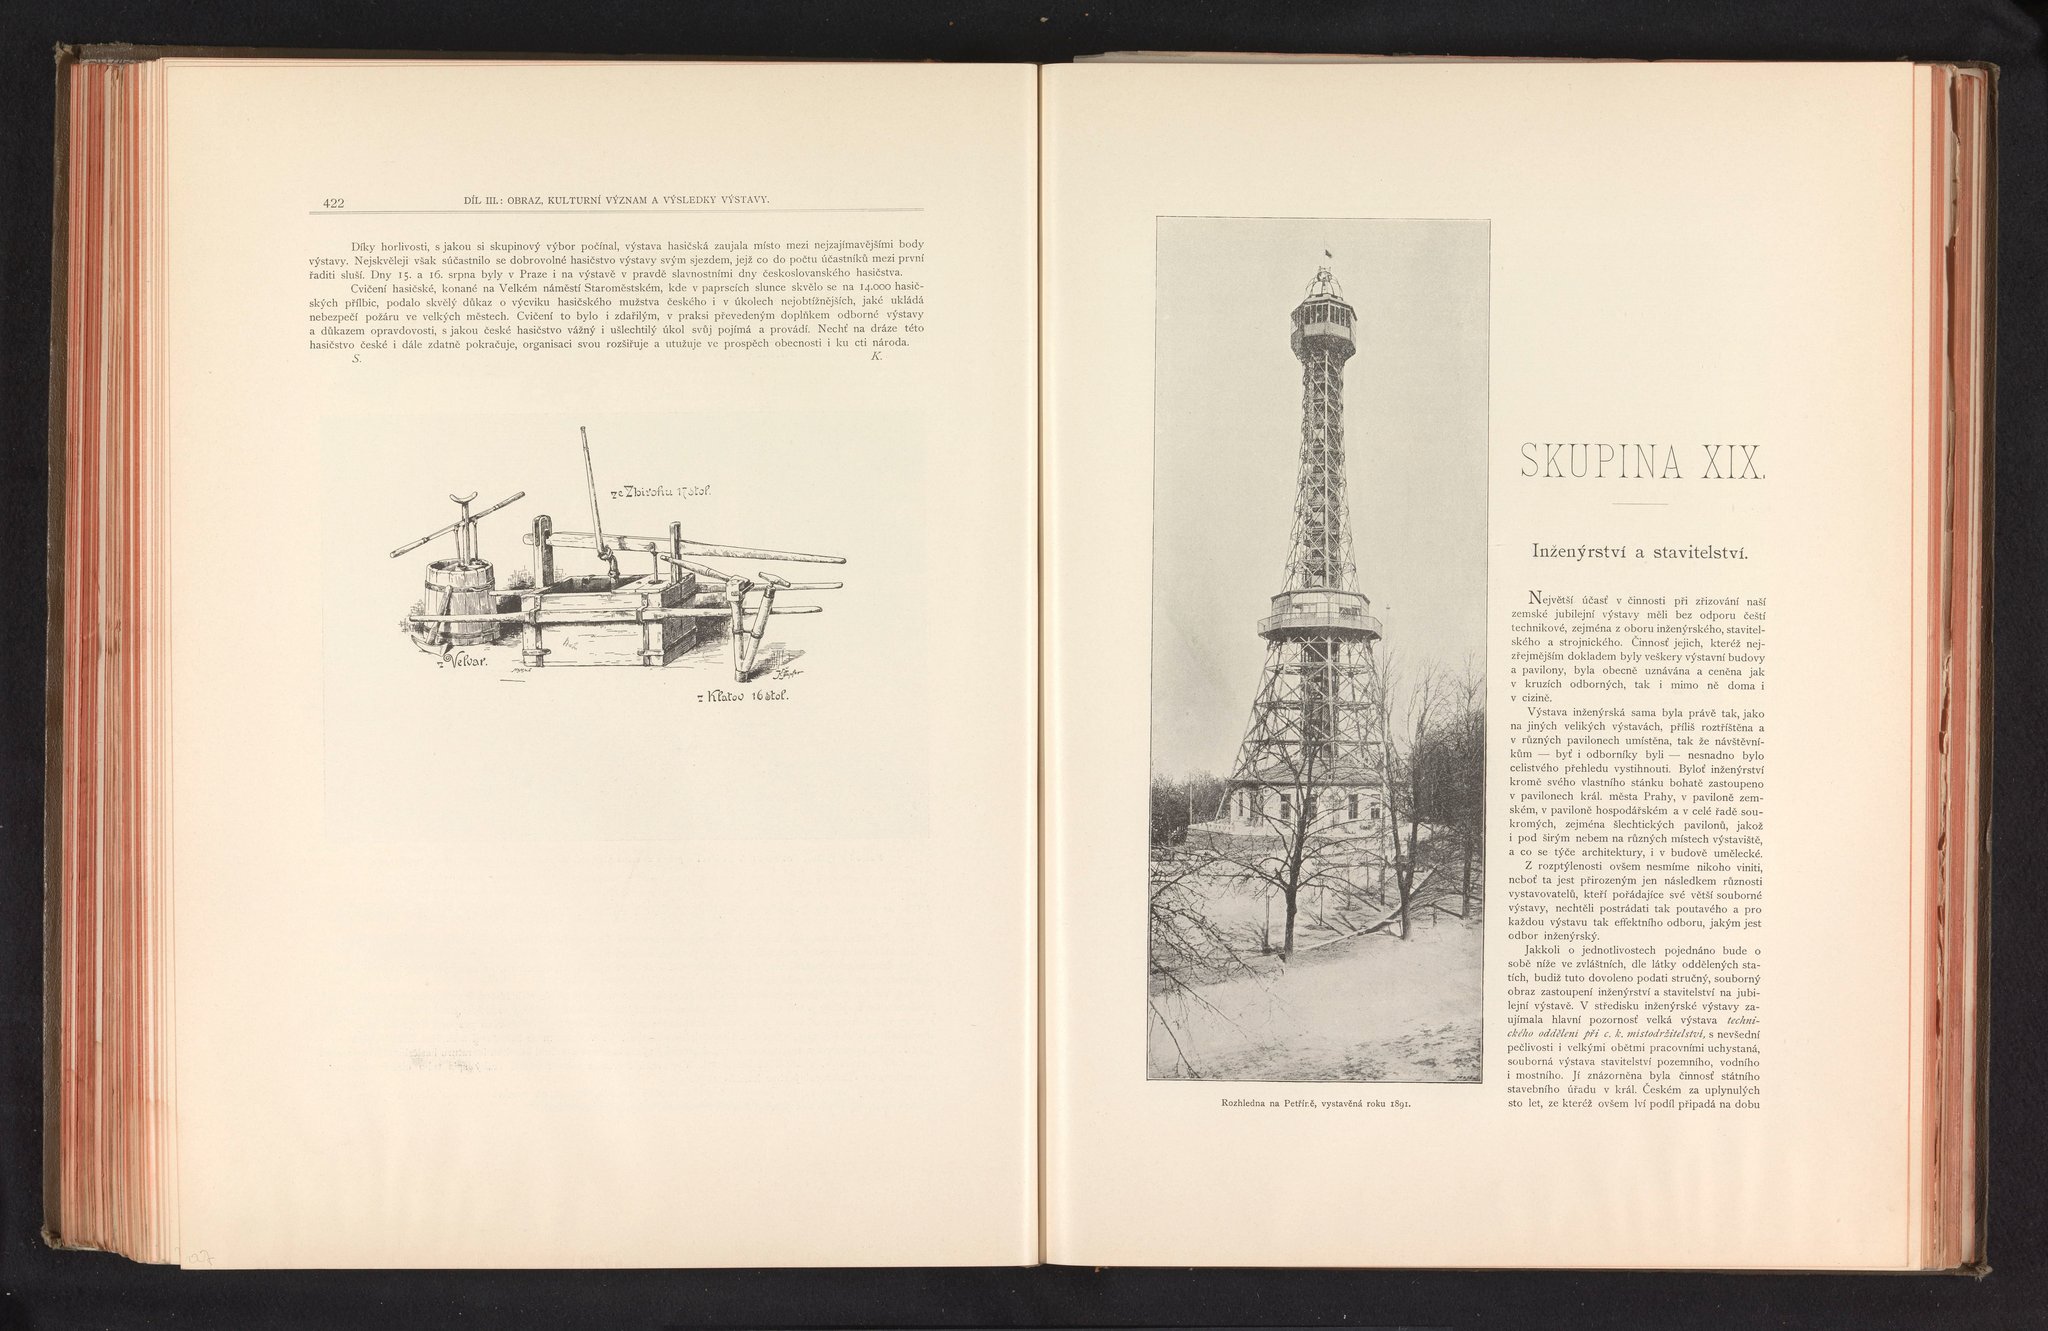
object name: page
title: Petřín-uitkijktoren te Praag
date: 1891-1895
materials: paper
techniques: autotype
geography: prague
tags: tower, clock tower ~ monumental adornment